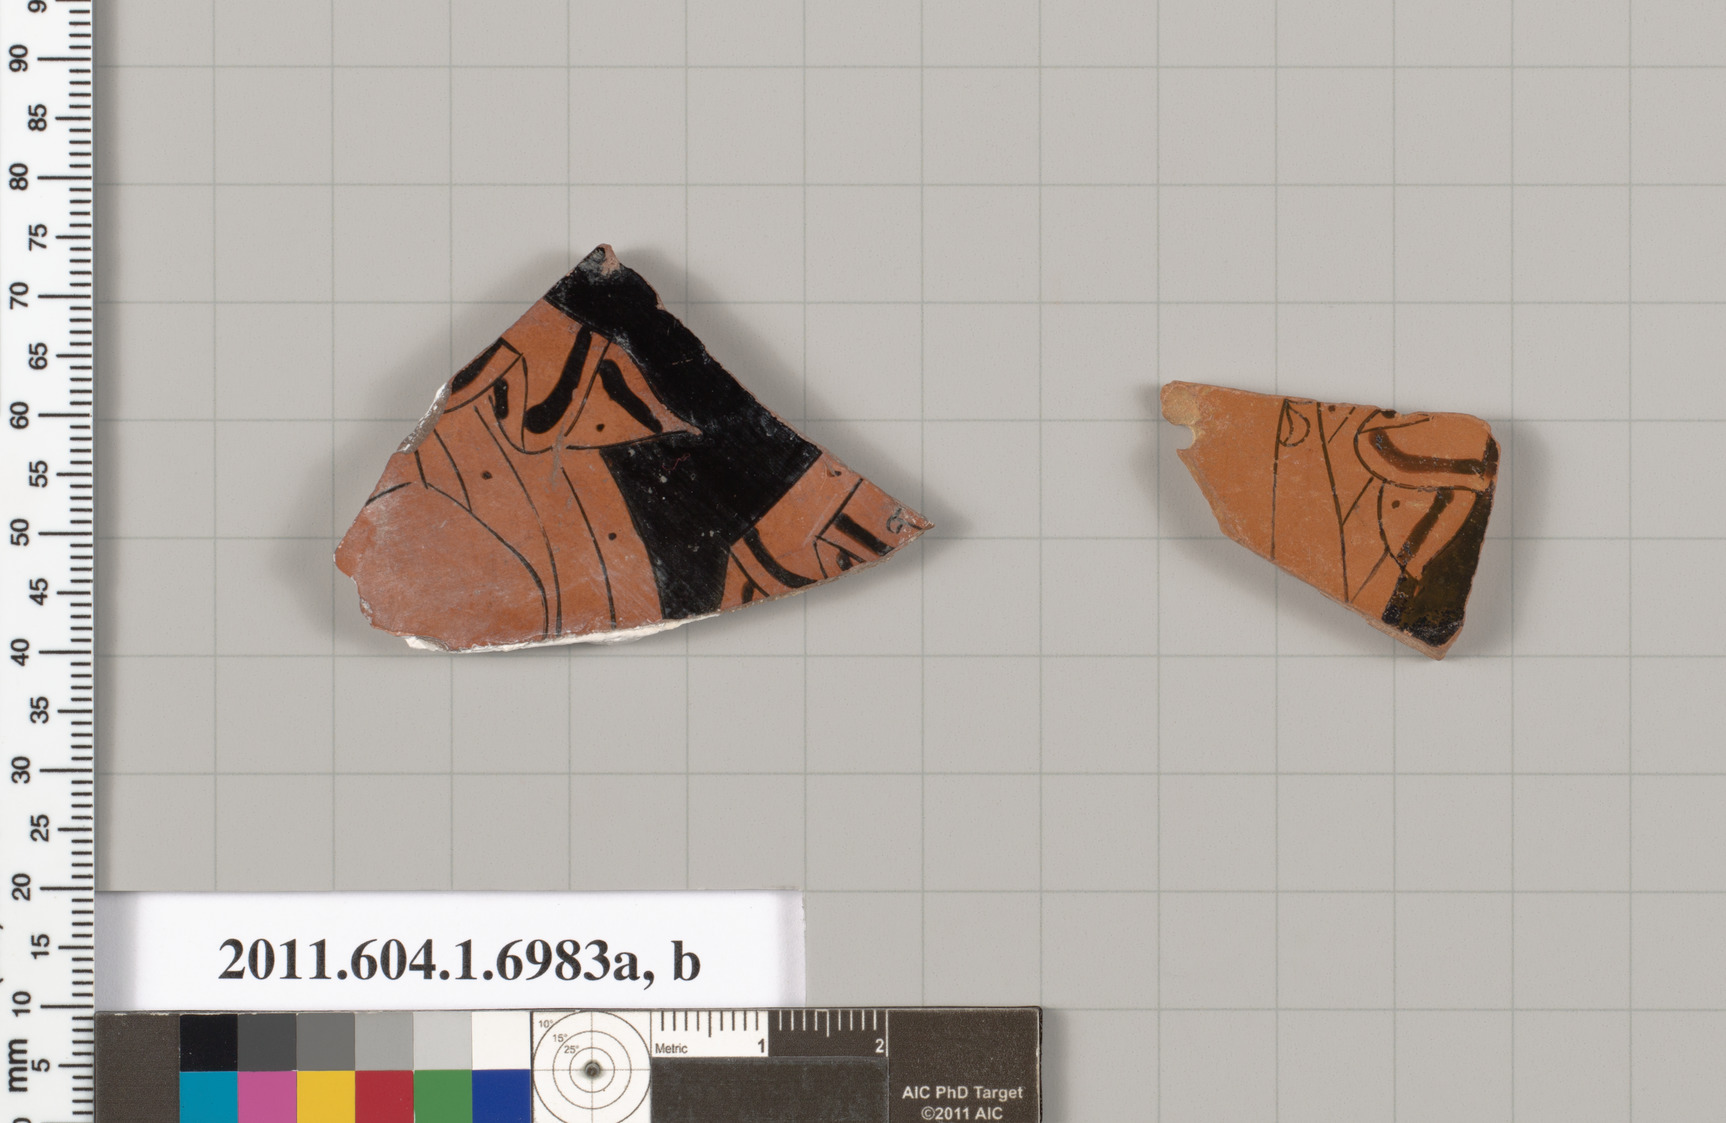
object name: kylix fragment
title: Terracotta fragments of a kylix (drinking cup)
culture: greek, attic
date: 480-470 BCE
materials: terracotta